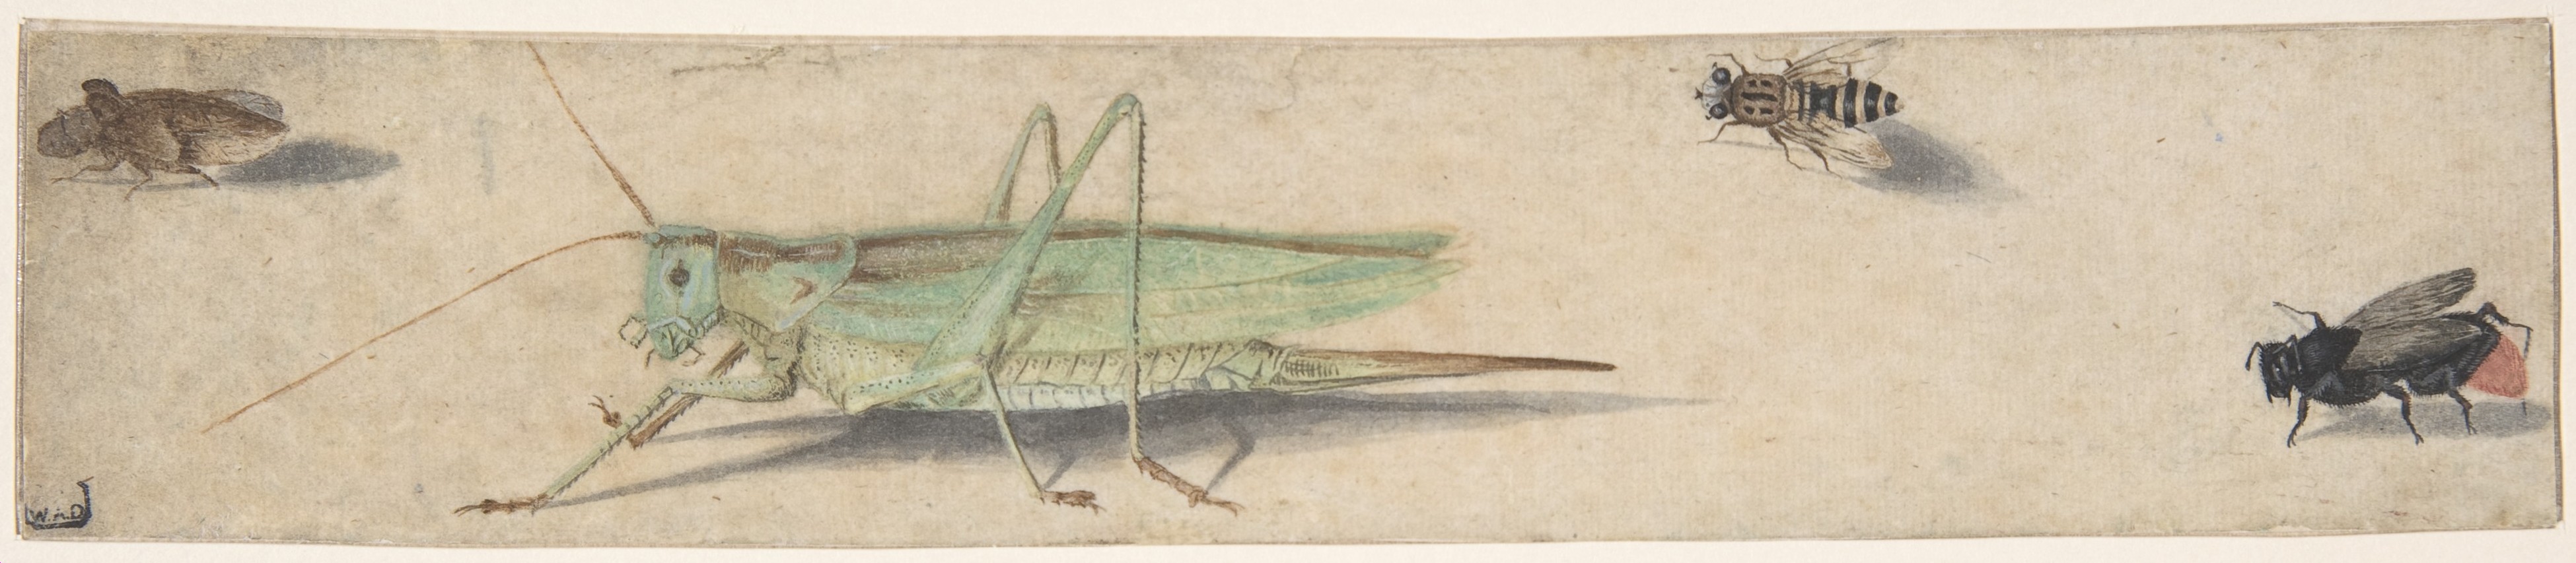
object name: drawing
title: A Katydid, a Fly, a Bee, and a Fulgoroid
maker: anonymous, dutch, 17th century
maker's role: artist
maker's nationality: dutch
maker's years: 1600-1700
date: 1601-1700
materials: gouache, ink, watercolor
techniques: pen, wash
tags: insects,bees